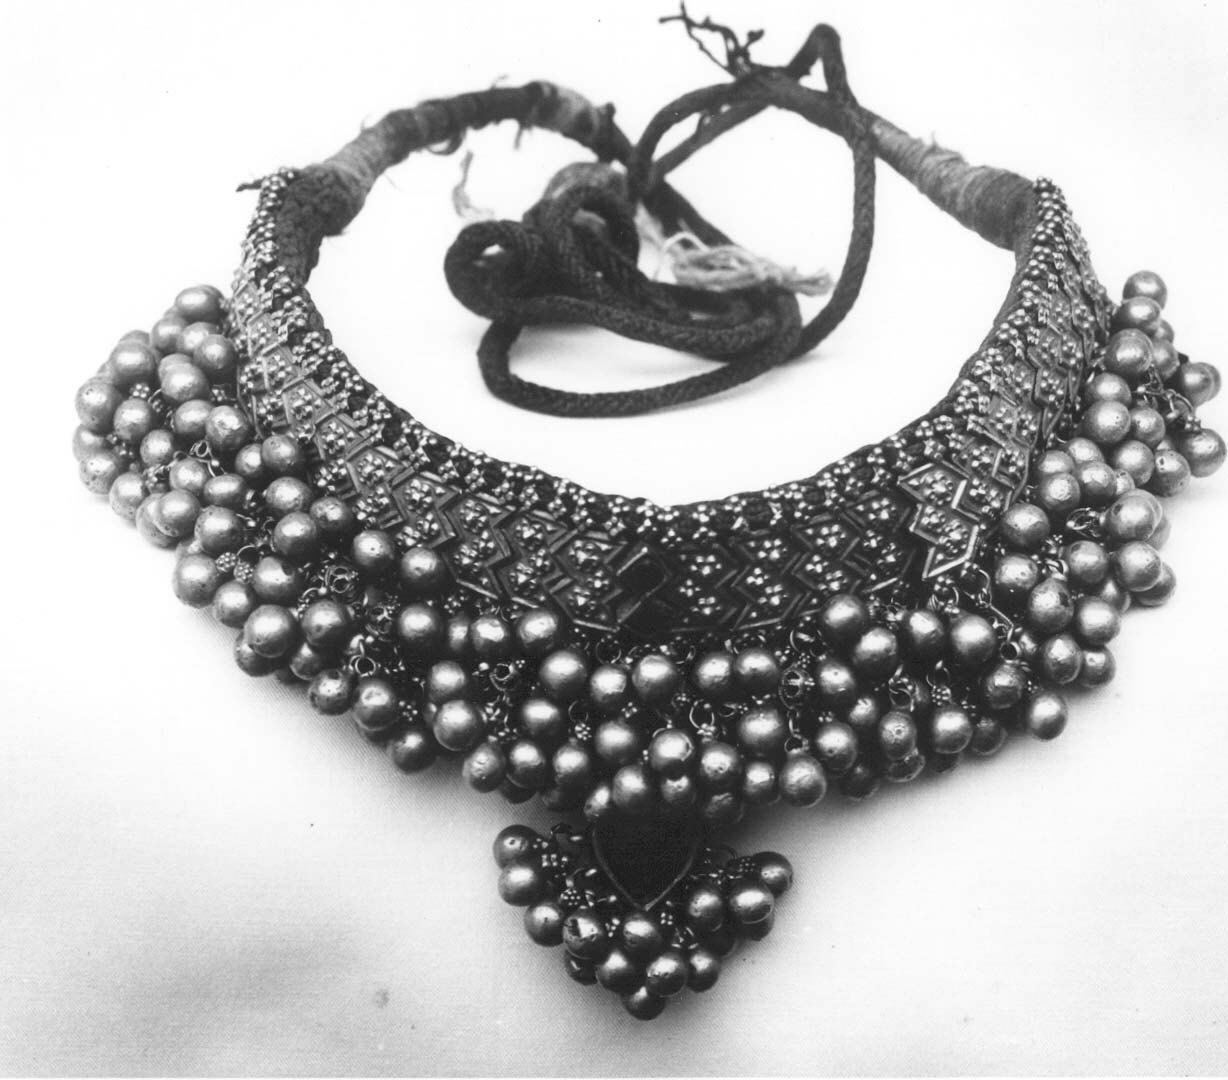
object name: necklace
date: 1701-1900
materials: gold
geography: india